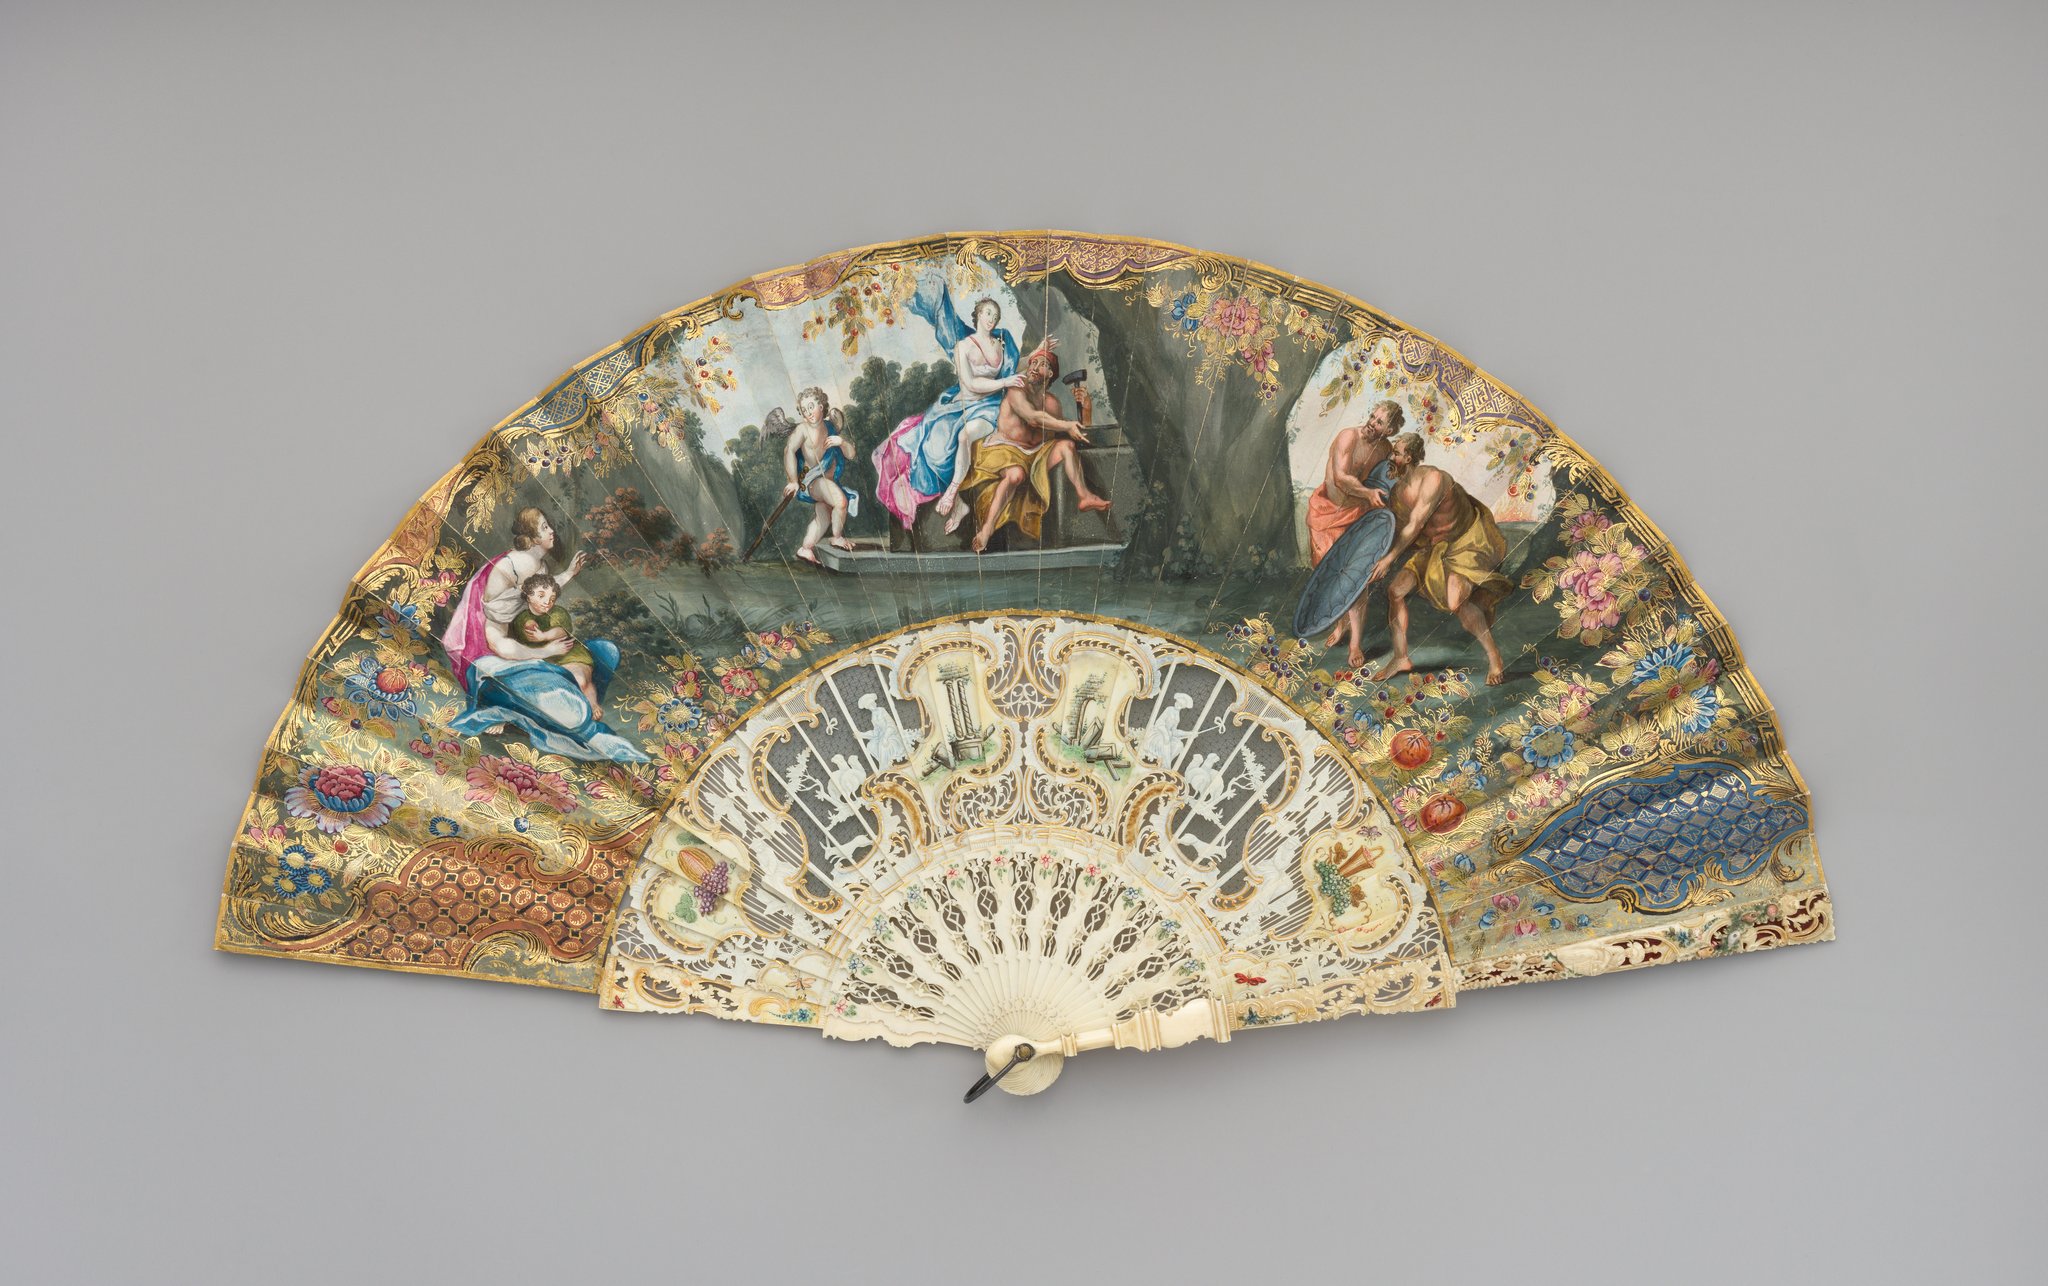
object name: fan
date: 1701-1800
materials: ivory, paper, shell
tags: men,women